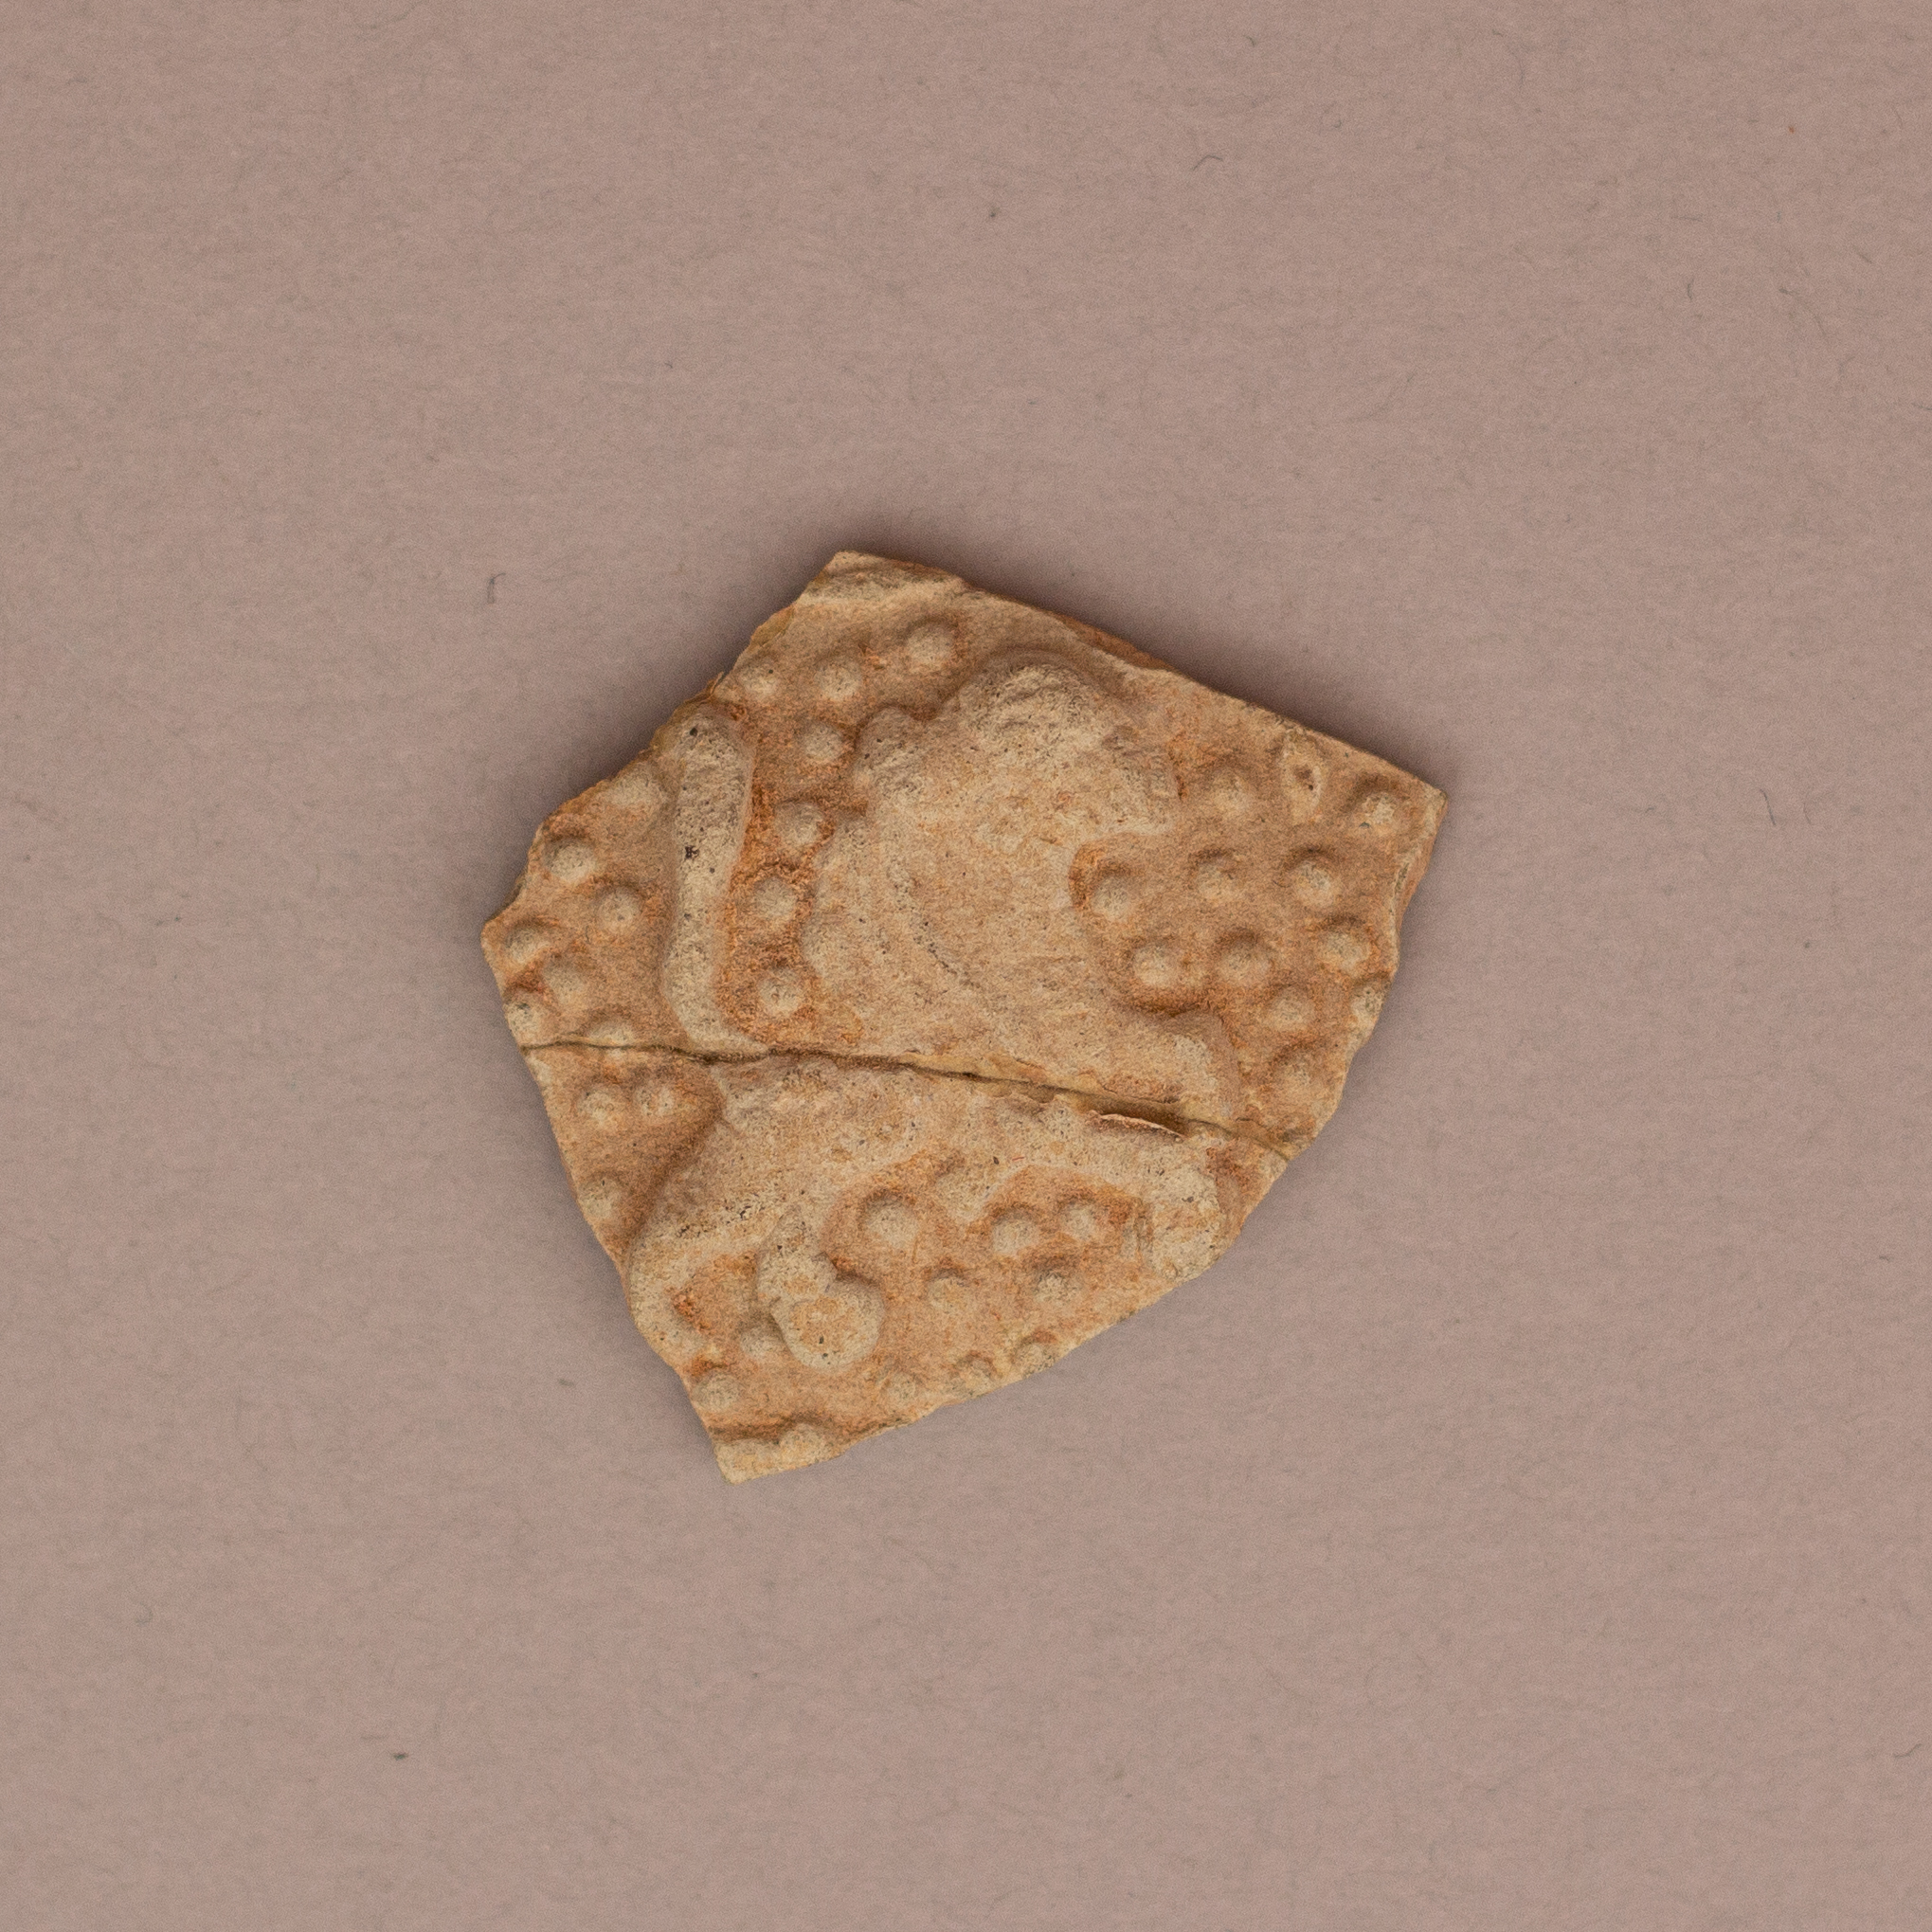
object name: fragment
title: Ceramic Fragment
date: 1001-1200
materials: earthenware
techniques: molding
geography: iran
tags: lions